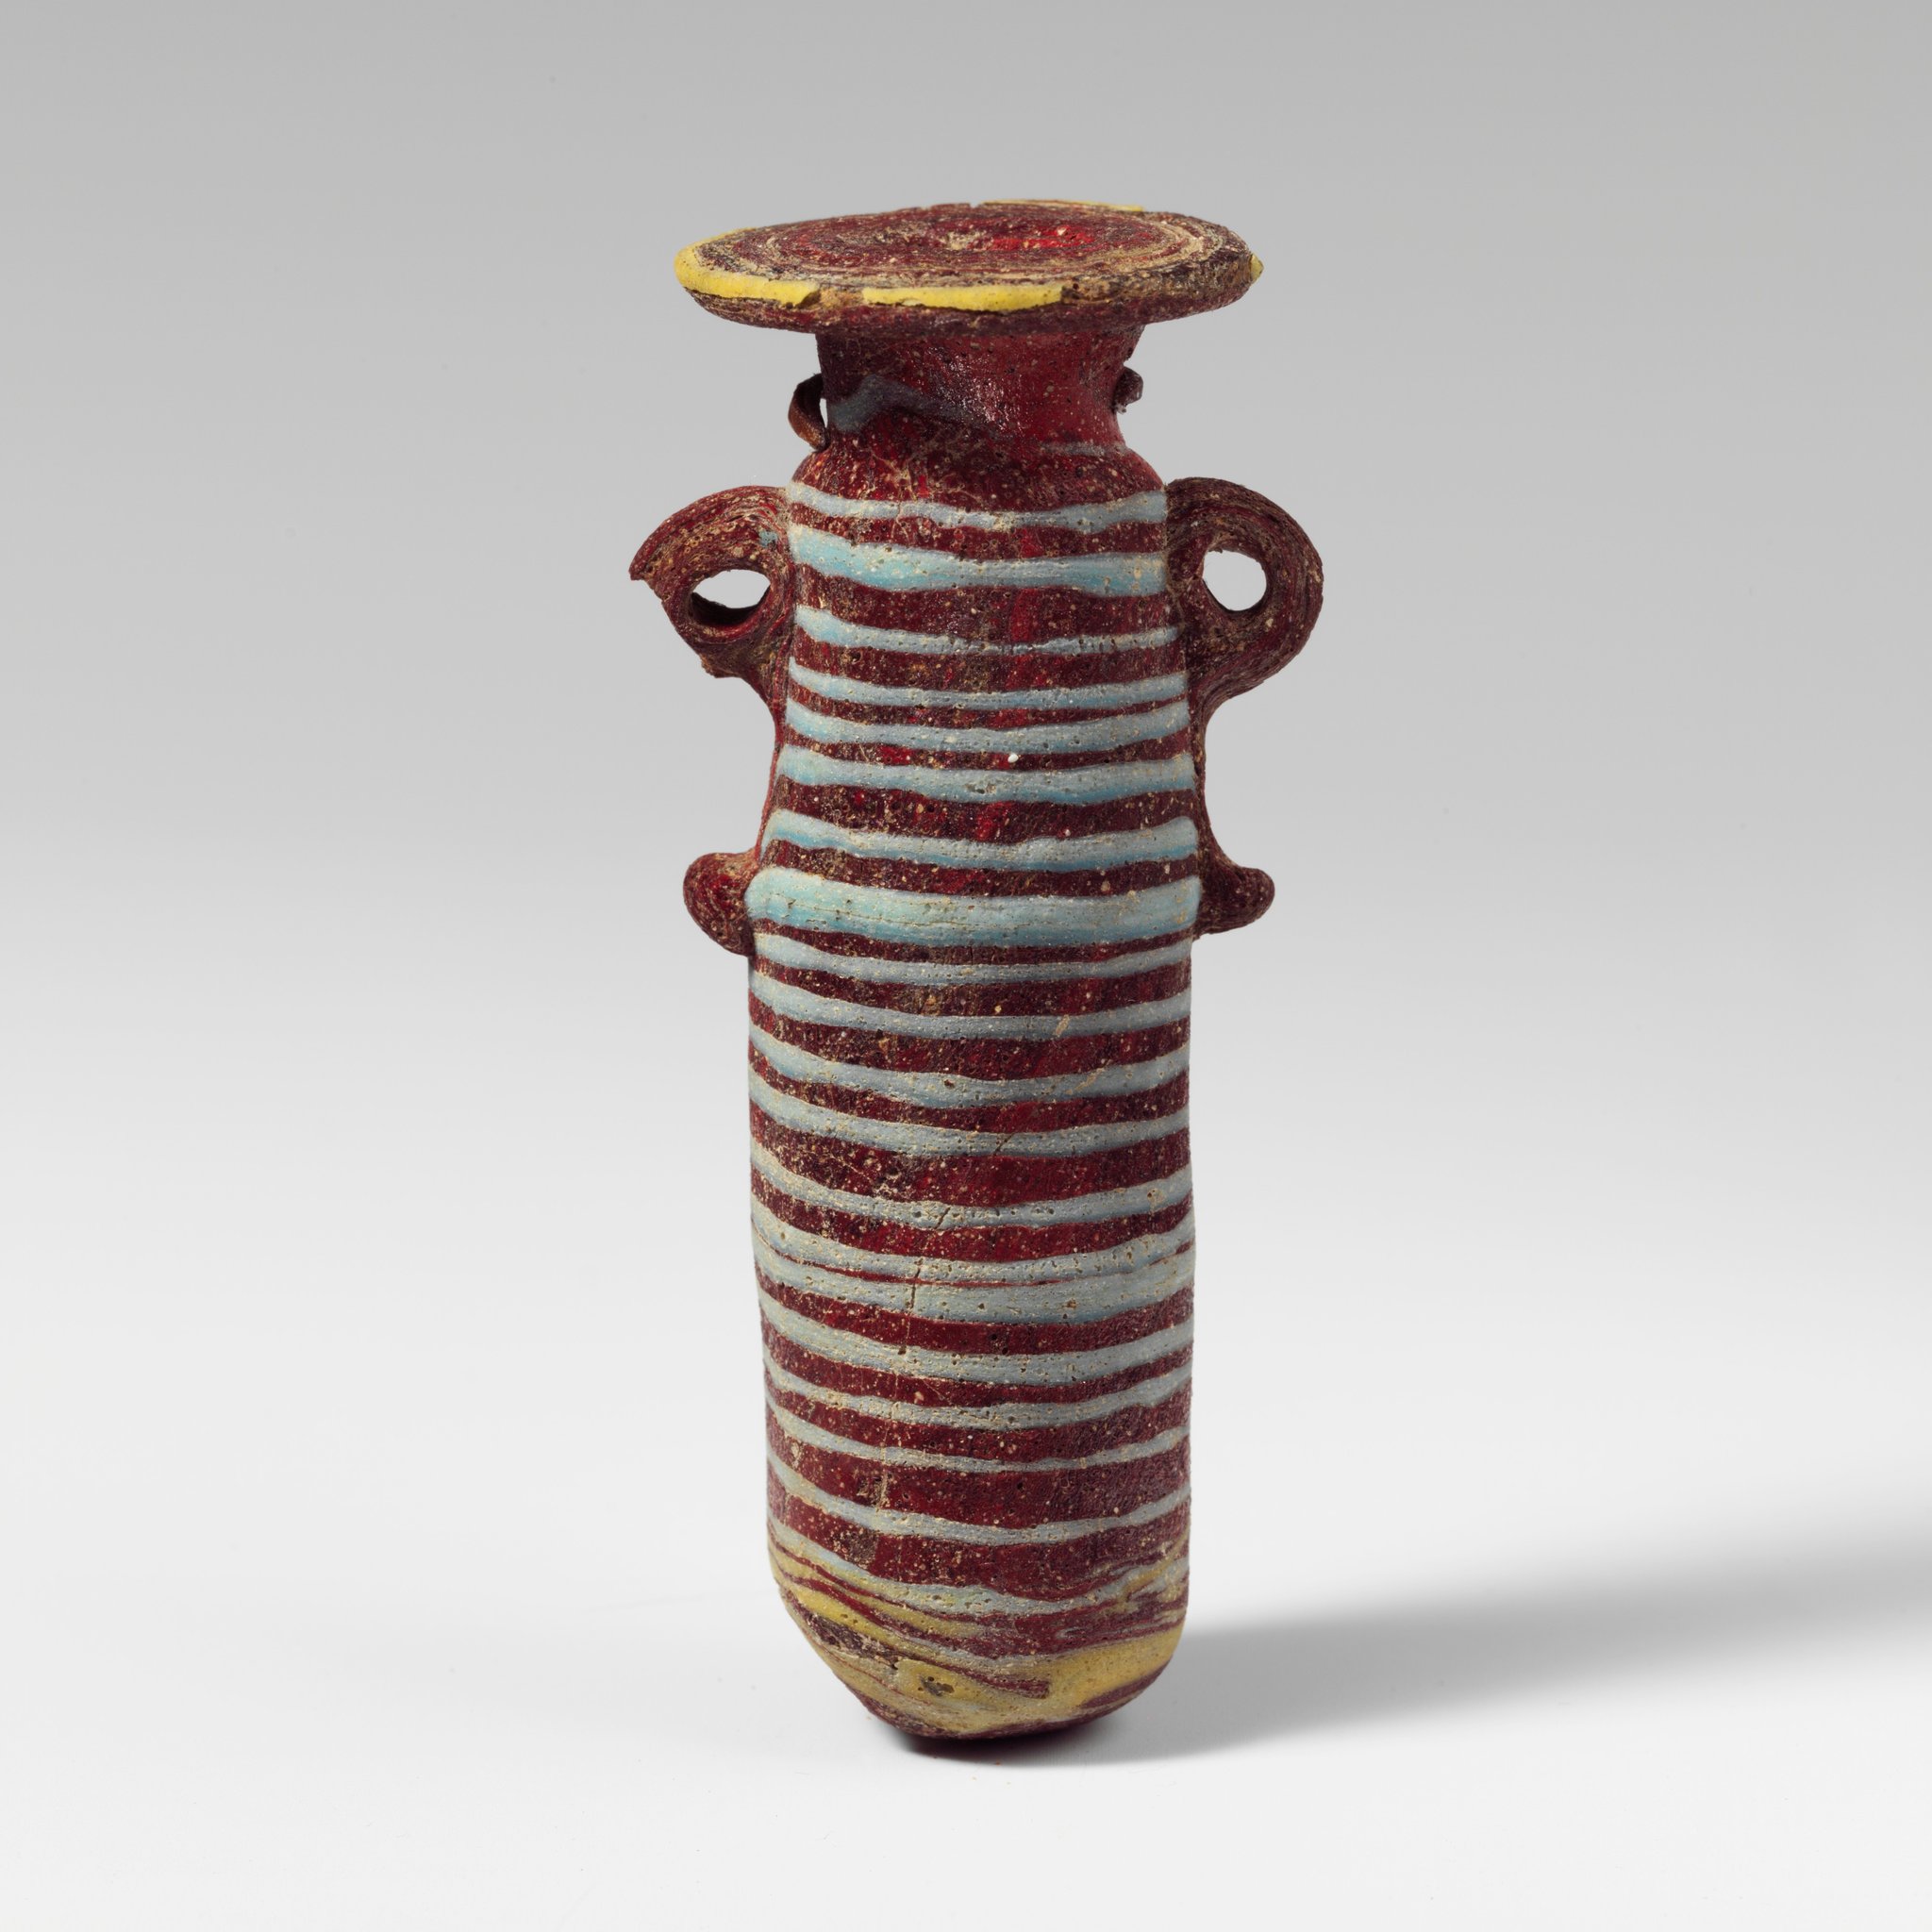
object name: alabastron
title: Glass alabastron (perfume bottle)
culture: greek, eastern mediterranean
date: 500-401 BCE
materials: glass